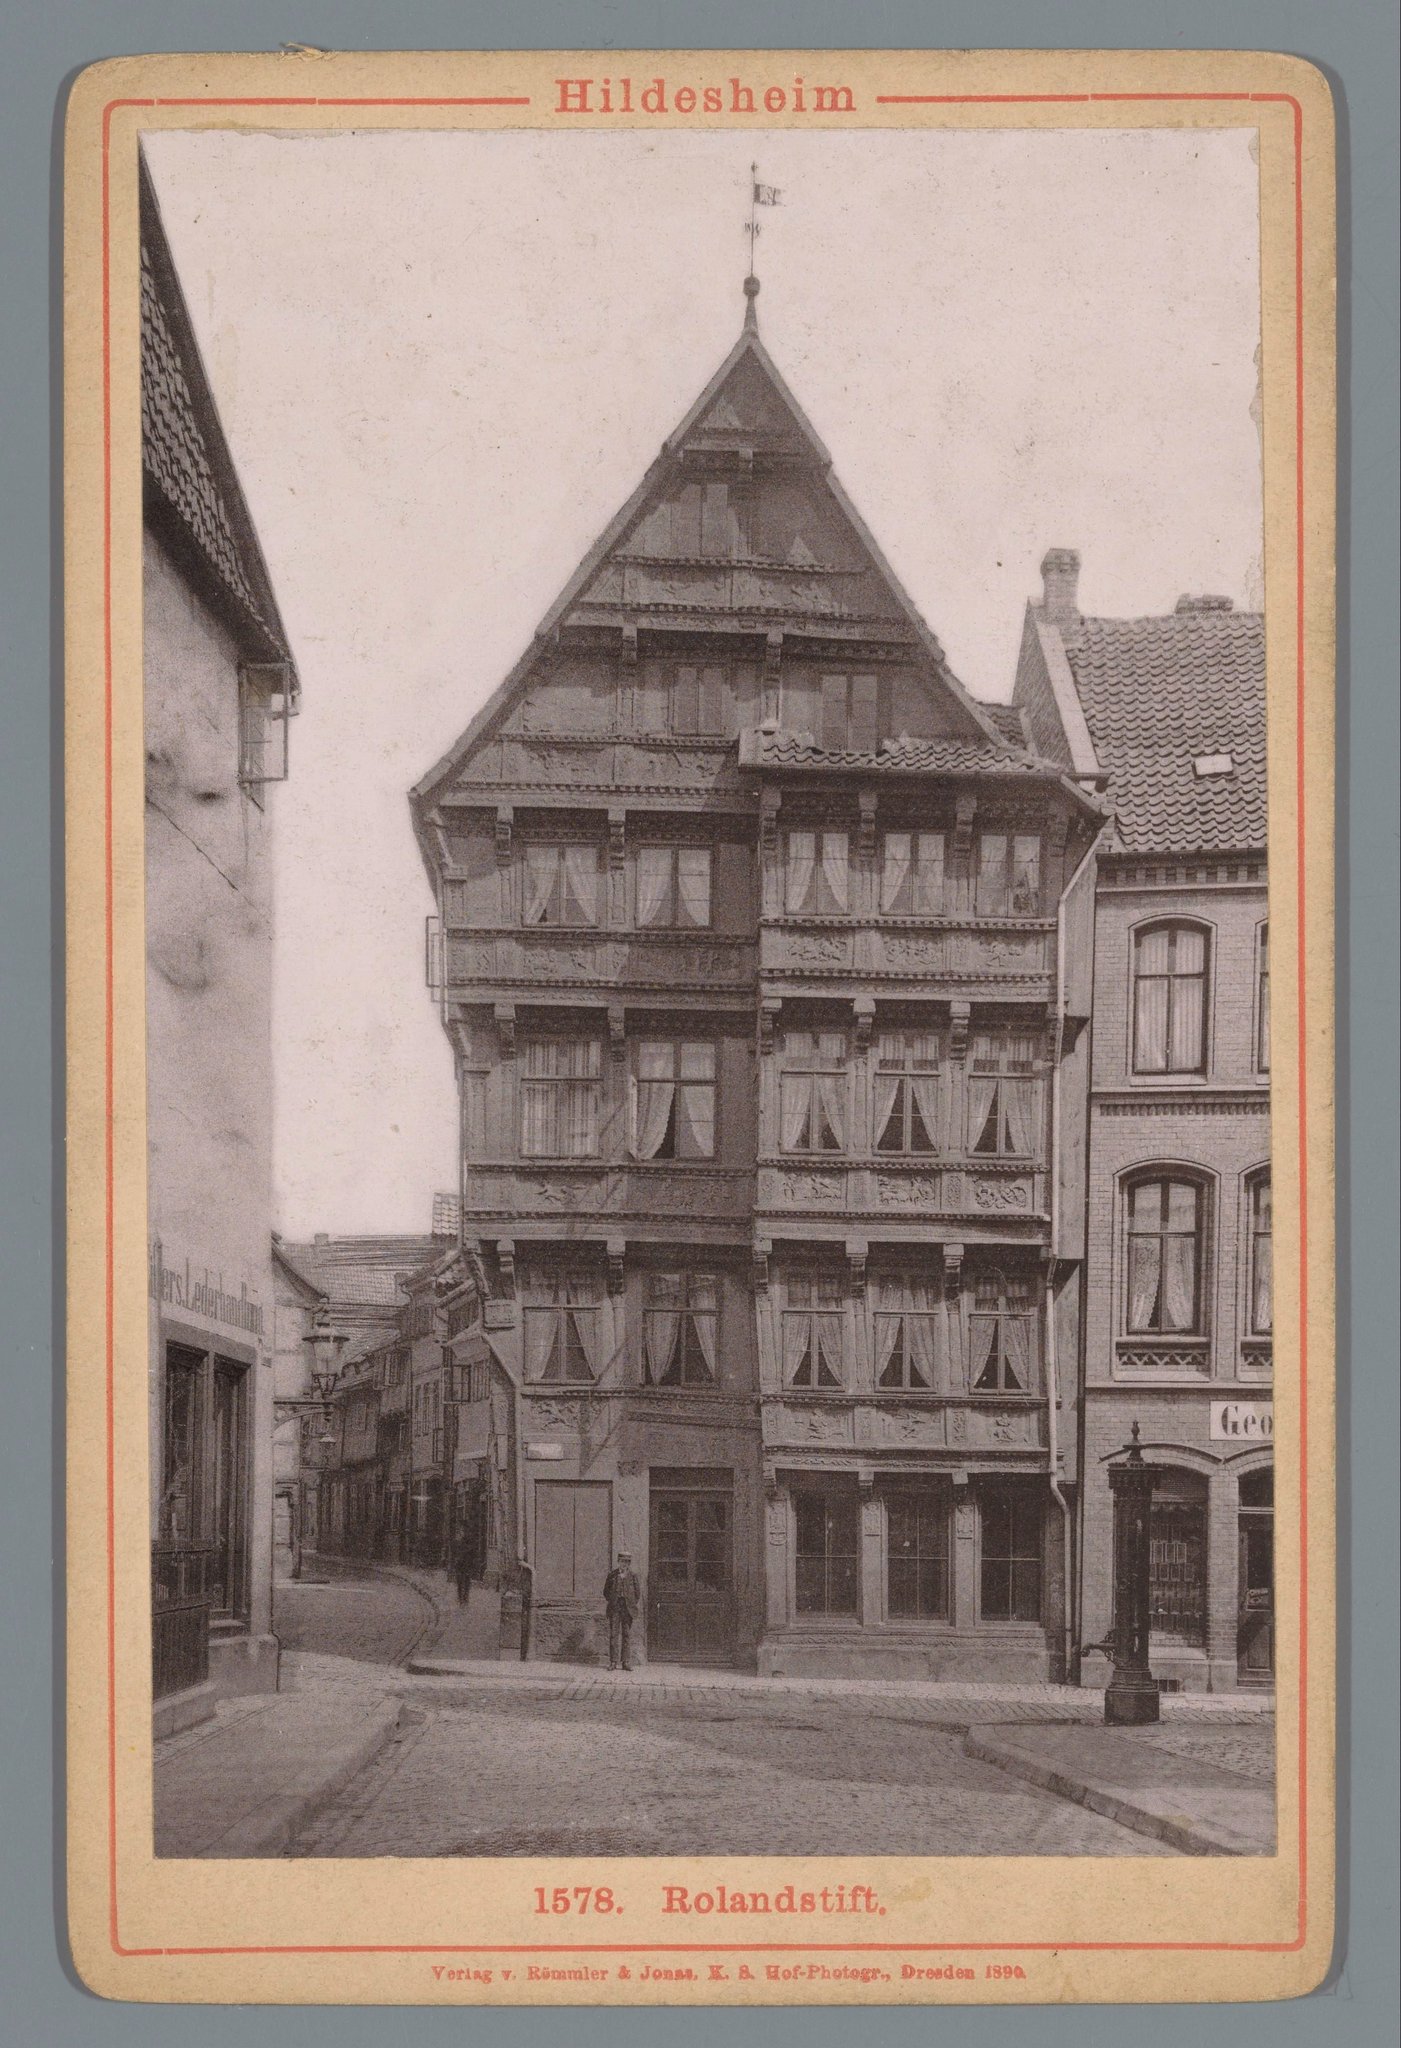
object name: cabinet photograph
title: Rolandstift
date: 1890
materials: cardboard, paper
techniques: photograph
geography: hildesheim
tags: hospital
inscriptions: number: ‘1578.’